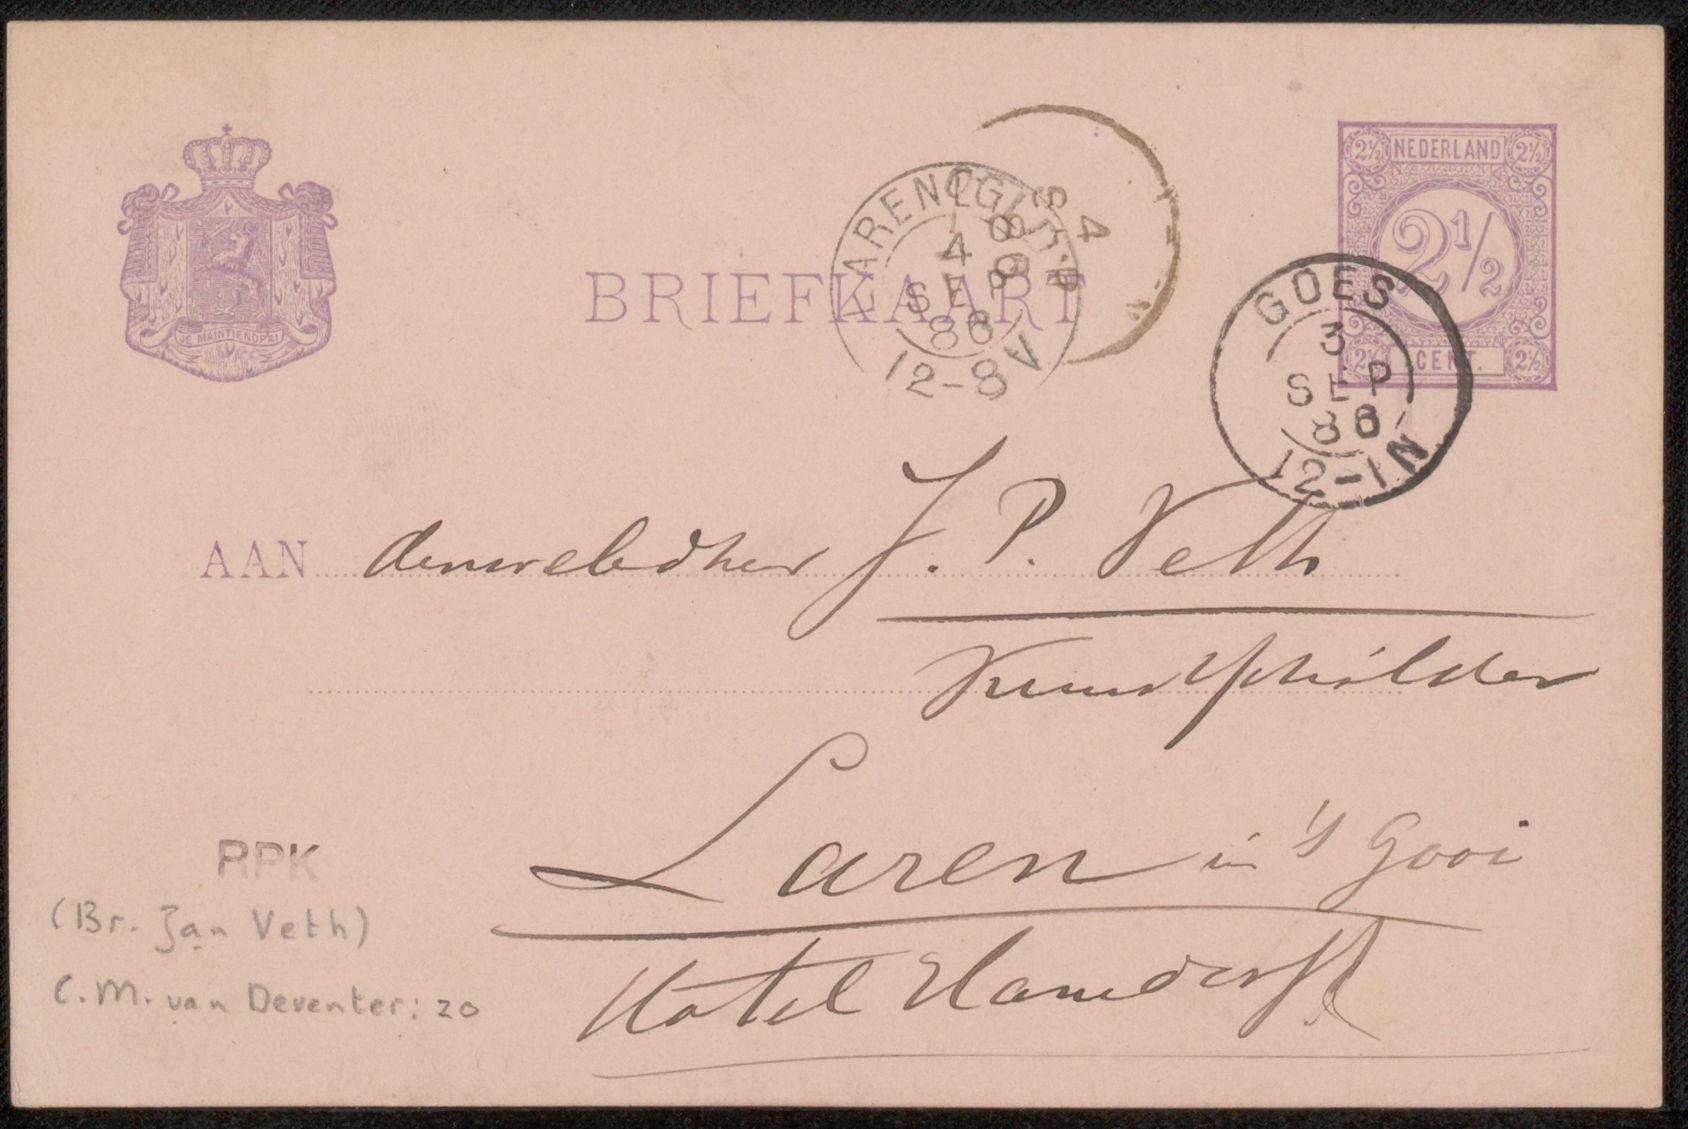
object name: postcard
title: Briefkaart aan Jan Veth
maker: chap van deventer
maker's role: kunstcriticus, scheikundige, schrijver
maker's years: 1860-1931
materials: cardboard, ink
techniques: pen, writing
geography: goes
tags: painter, print maker, draughtsman, jan veth, paris, exhibition ~ art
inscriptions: collector's mark: ‘RPK’